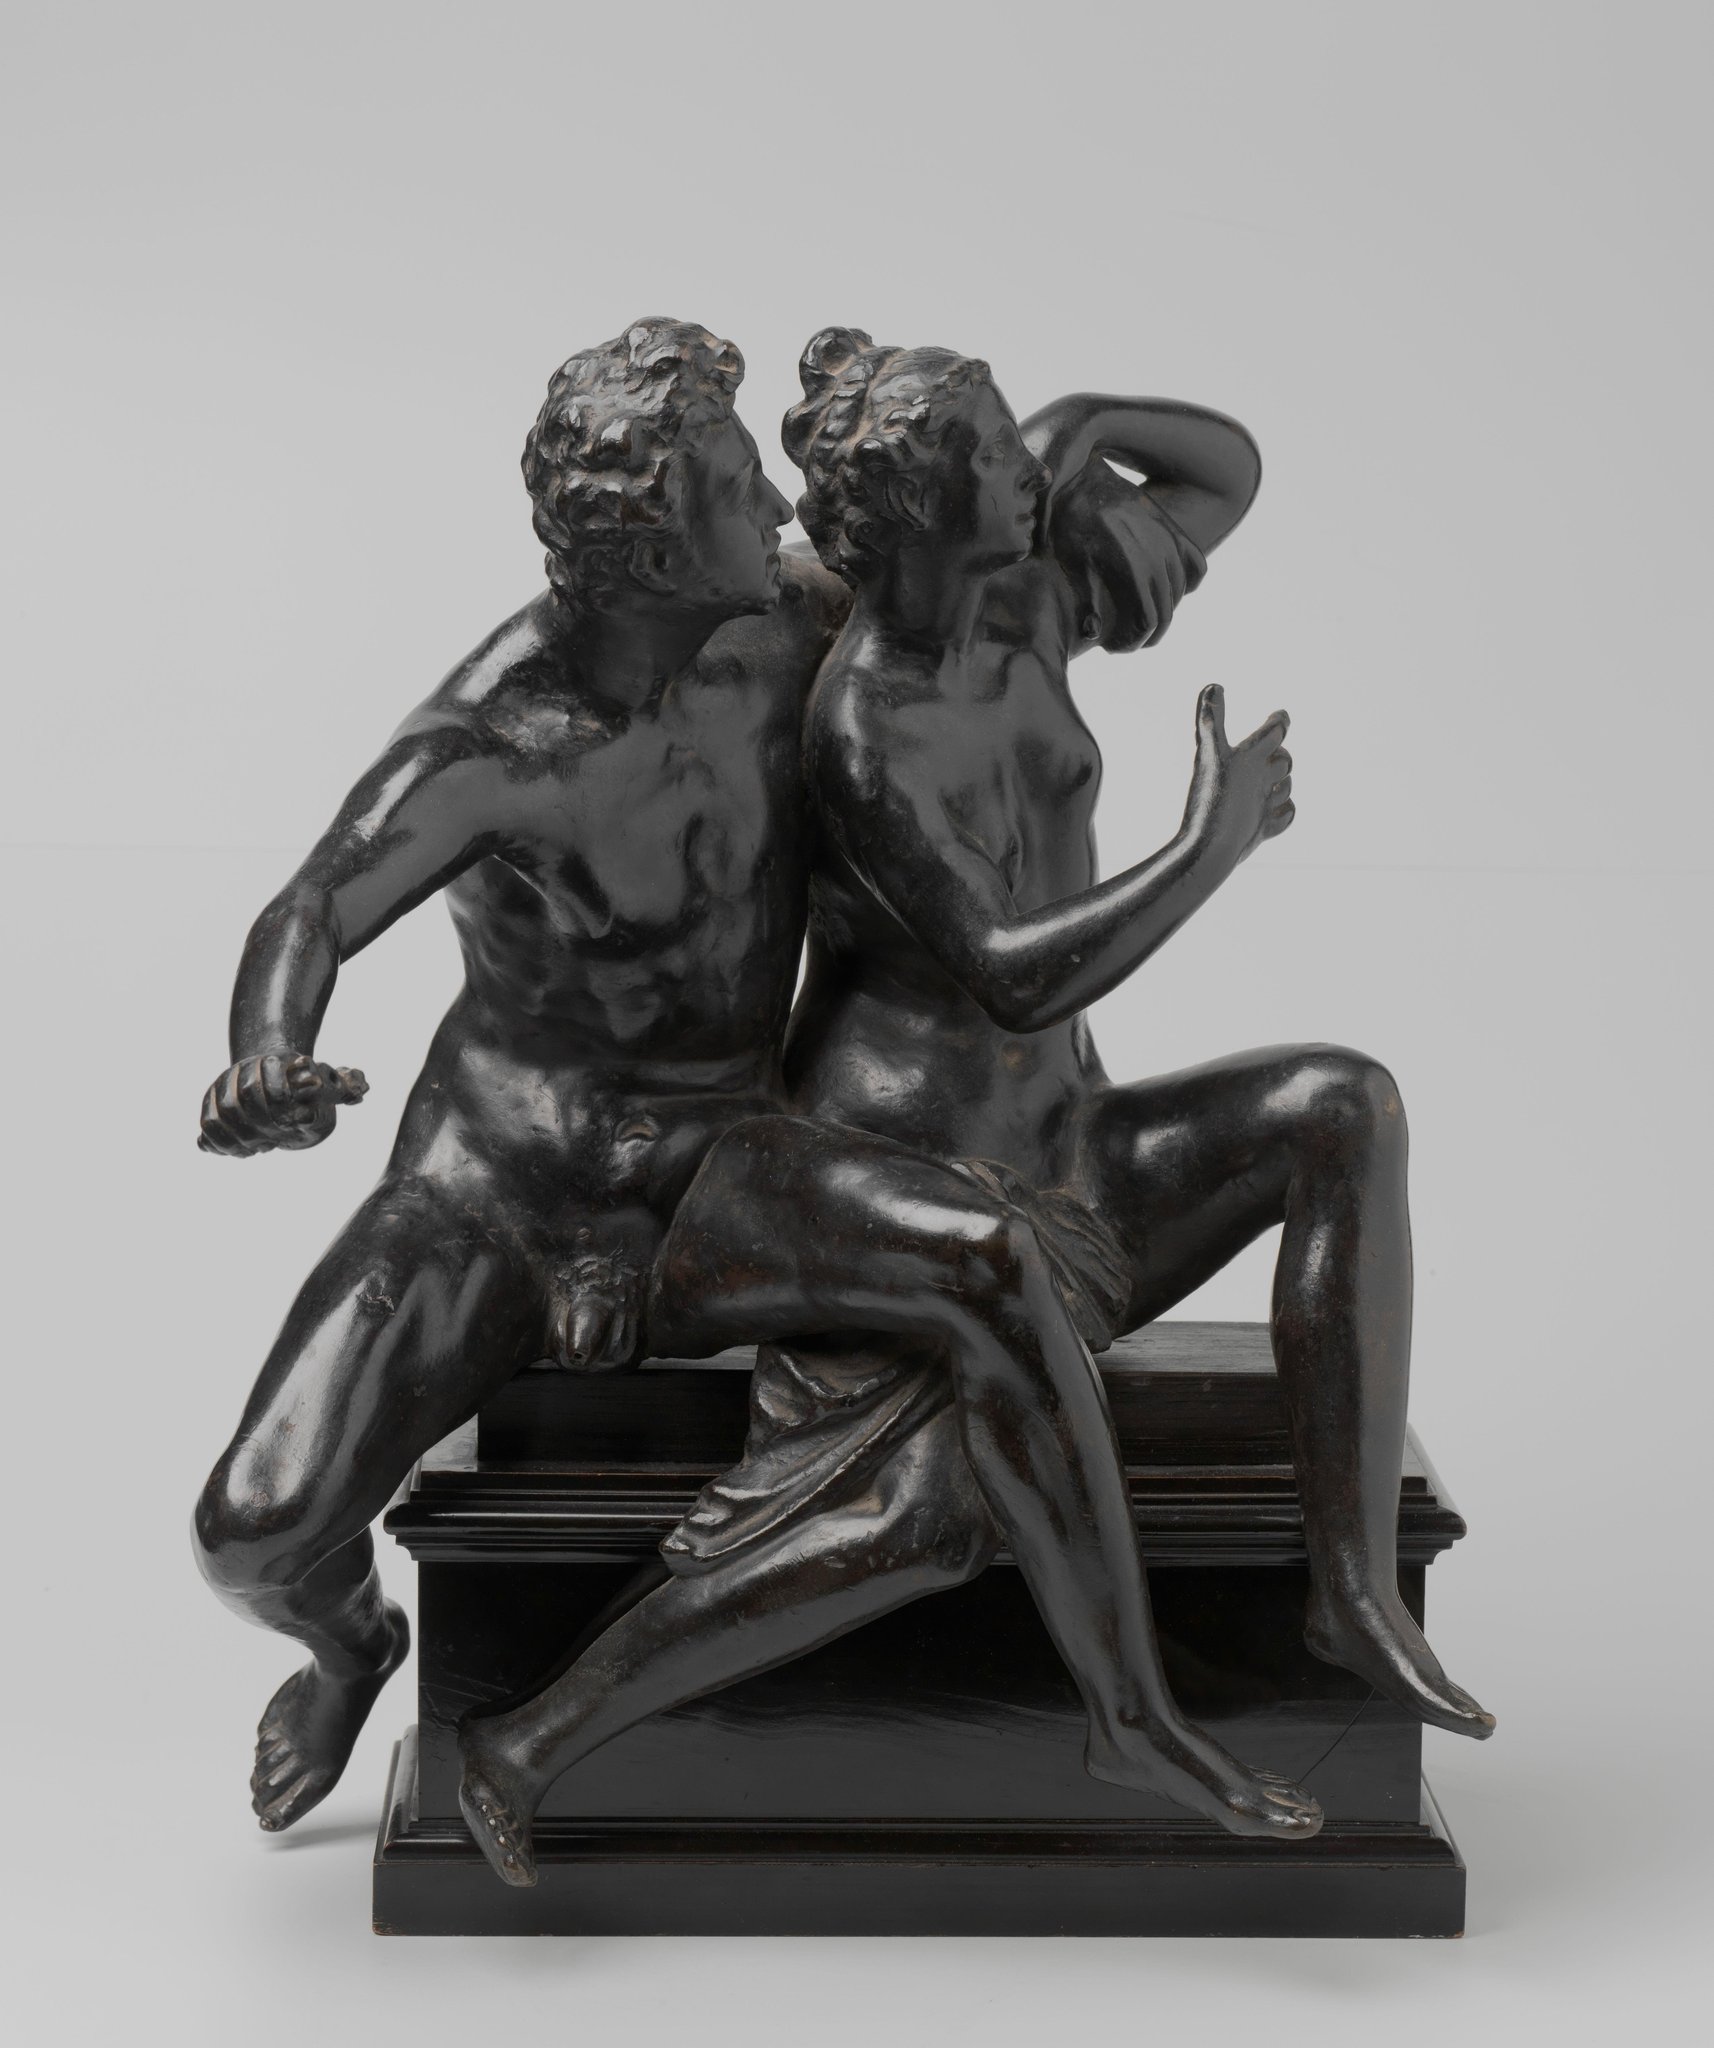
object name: sculpture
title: Sextus Tarquinius and Lucretia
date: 1600-1700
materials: bronze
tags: the rape of lucretia: sextus tarquin threatens her with a dagger or a sword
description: Adriaen de Vries (c. 1556 - 1626), after. Sextus Tarquinius and Lucrece. Bronze, massive cast. South Germany, c. 1600 - 1650.